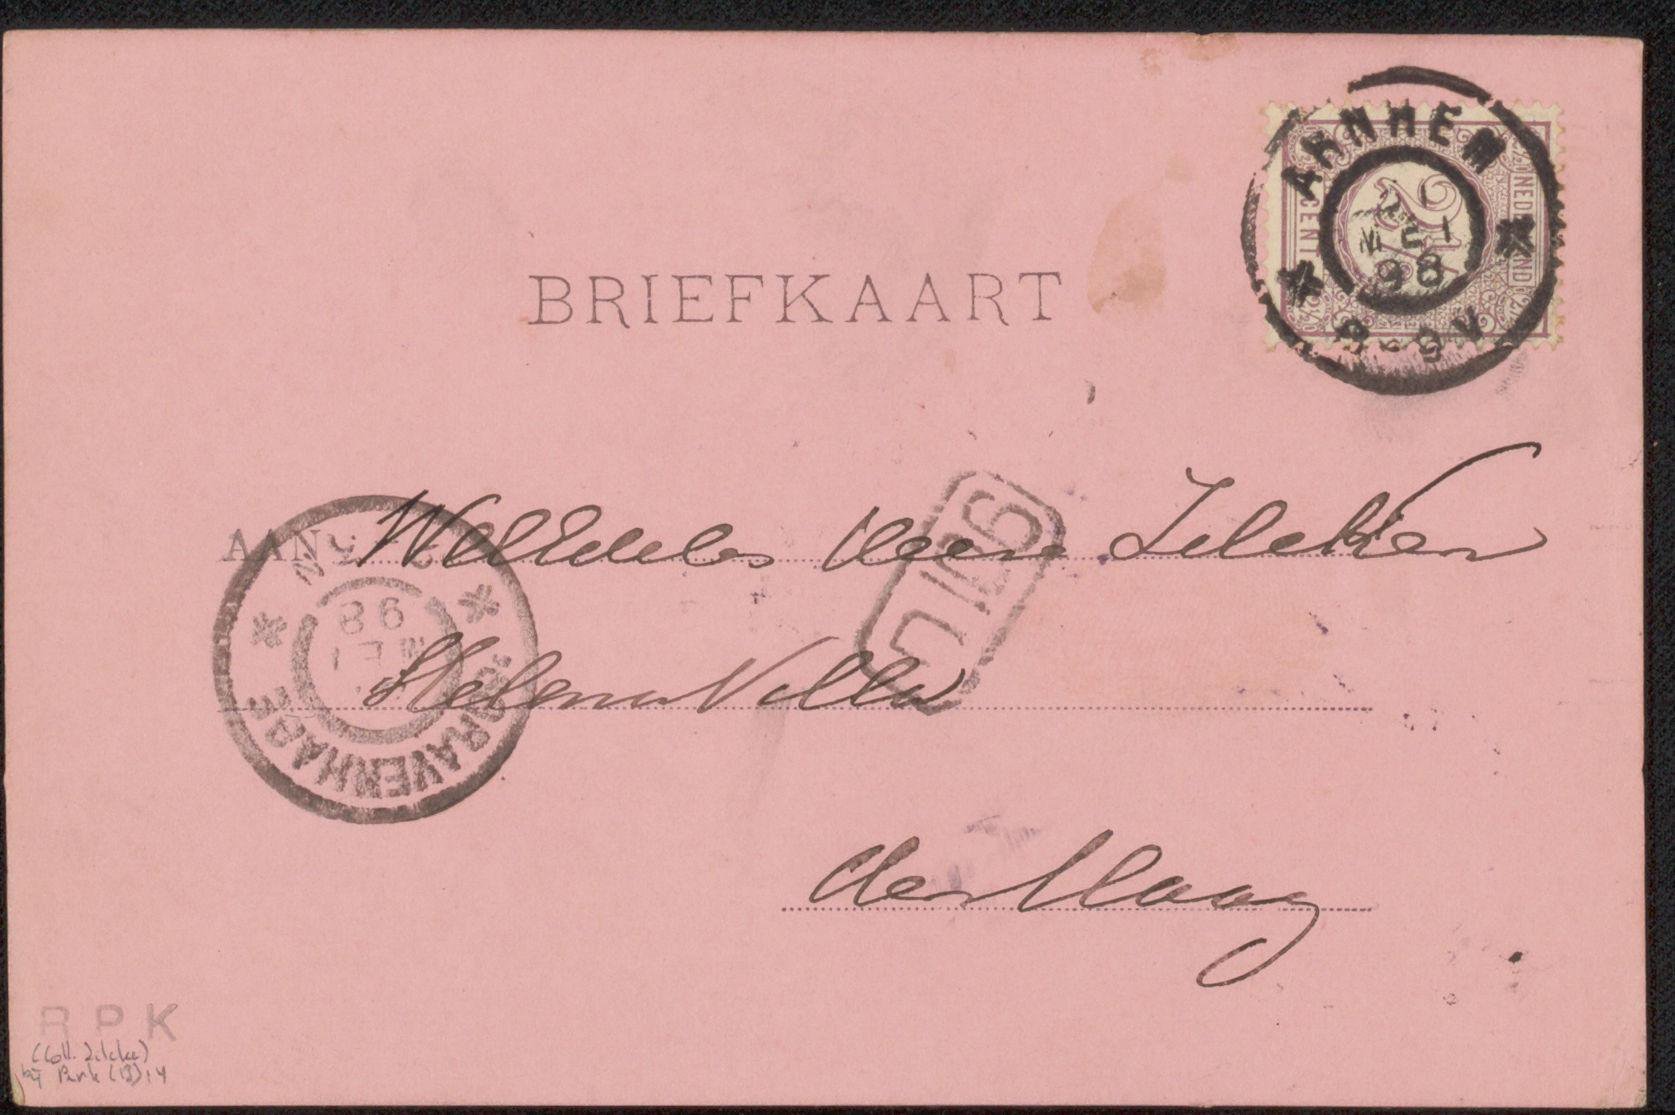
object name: postcard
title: Briefkaart aan Philip Zilcken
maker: christina elizabeth perk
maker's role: painter, sculptor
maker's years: 1833-1906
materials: cardboard, ink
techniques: pen, writing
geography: arnhem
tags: the hague, painter, draughtsman, philip zilcken, exhibition ~ art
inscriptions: collector's mark: ‘RPK’